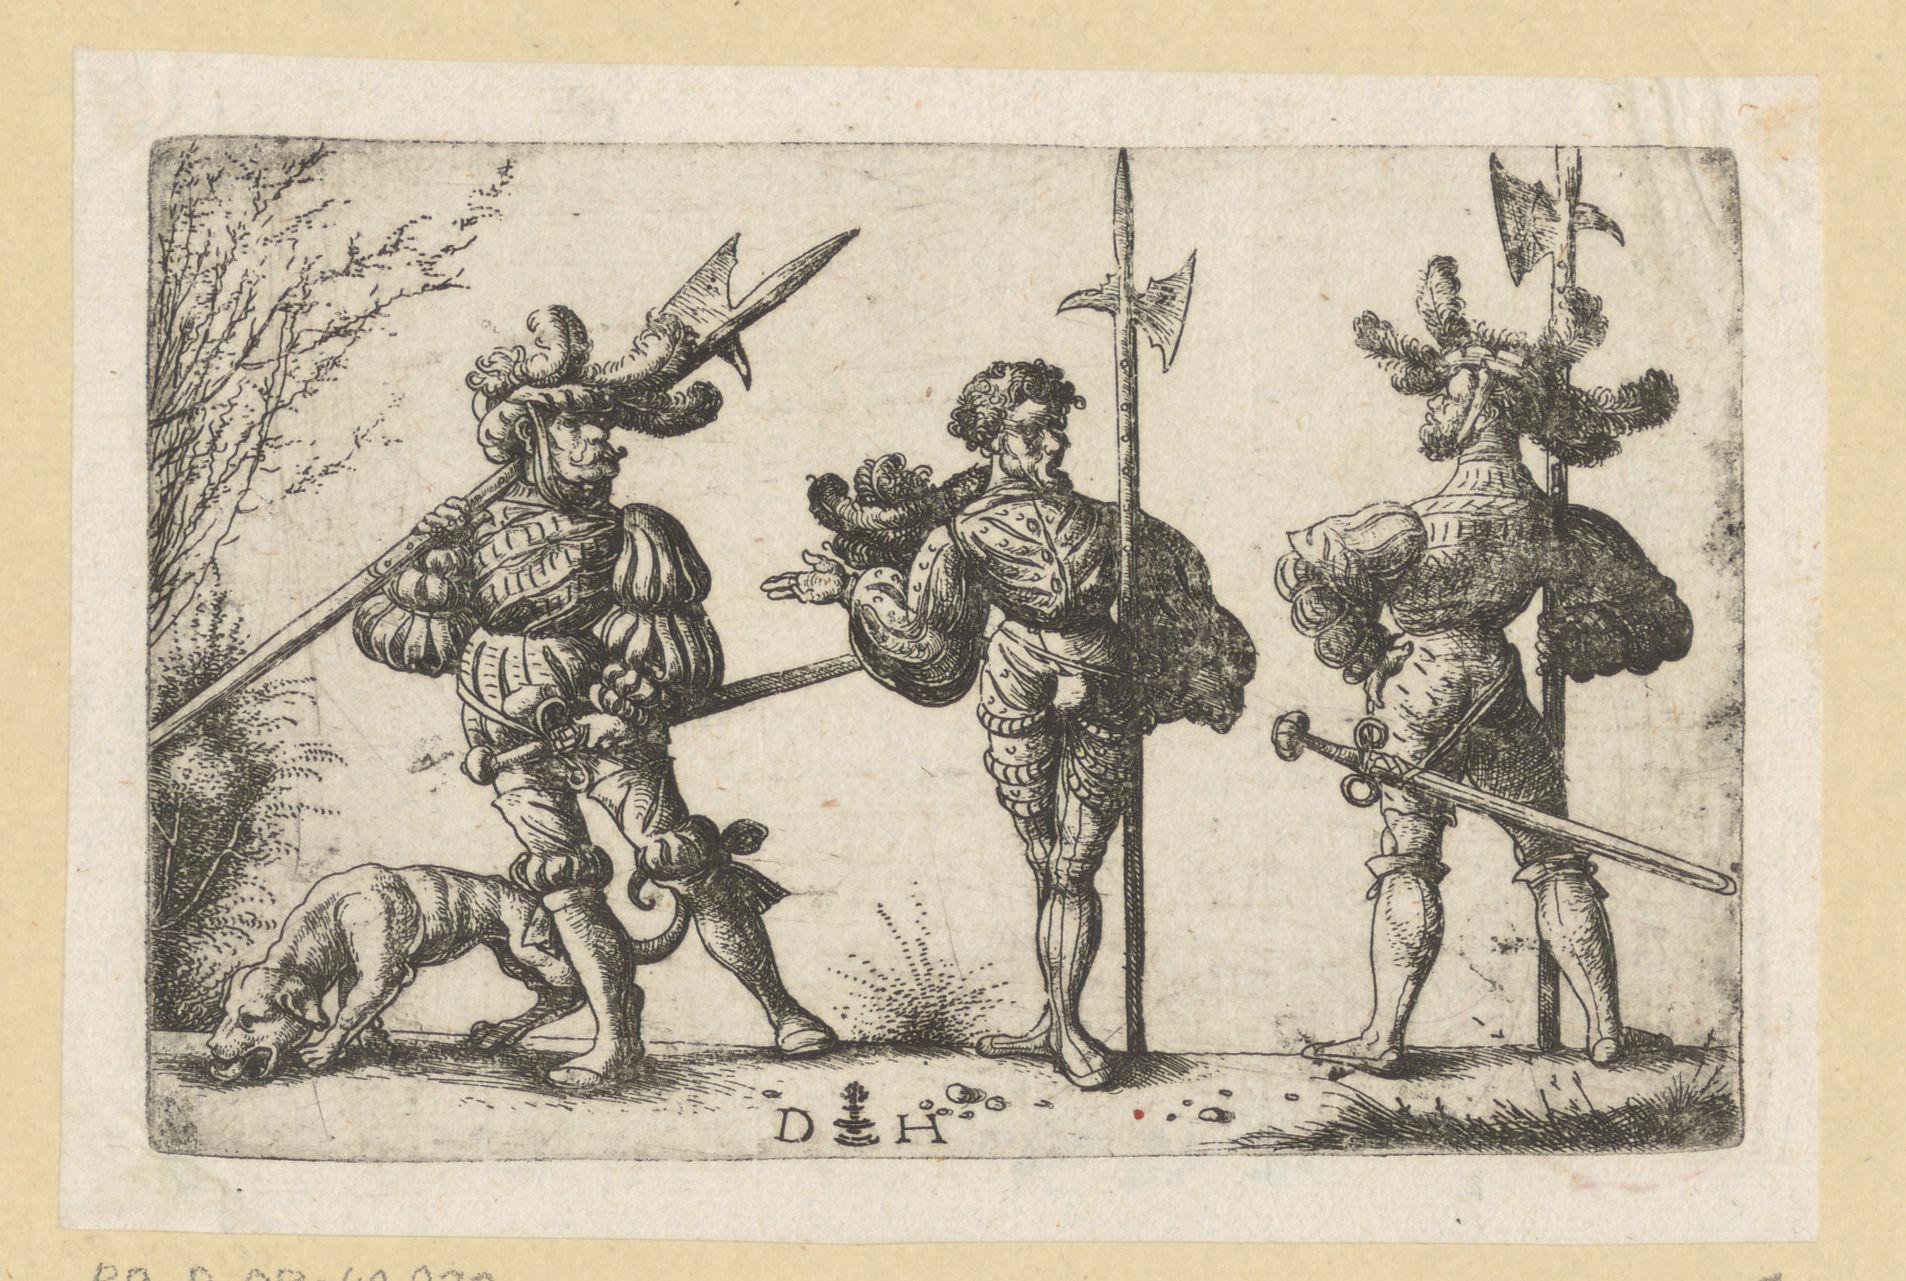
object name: print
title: Drie Duitse landsknechten met een hellebaard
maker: daniel hopfer (i)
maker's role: print maker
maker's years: 1470-1536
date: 1504-1536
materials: paper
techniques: etching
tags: the soldier; the soldier's life, helved weapons, polearms (for striking, hacking, thrusting): halberd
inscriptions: collector's mark: Lugt 240